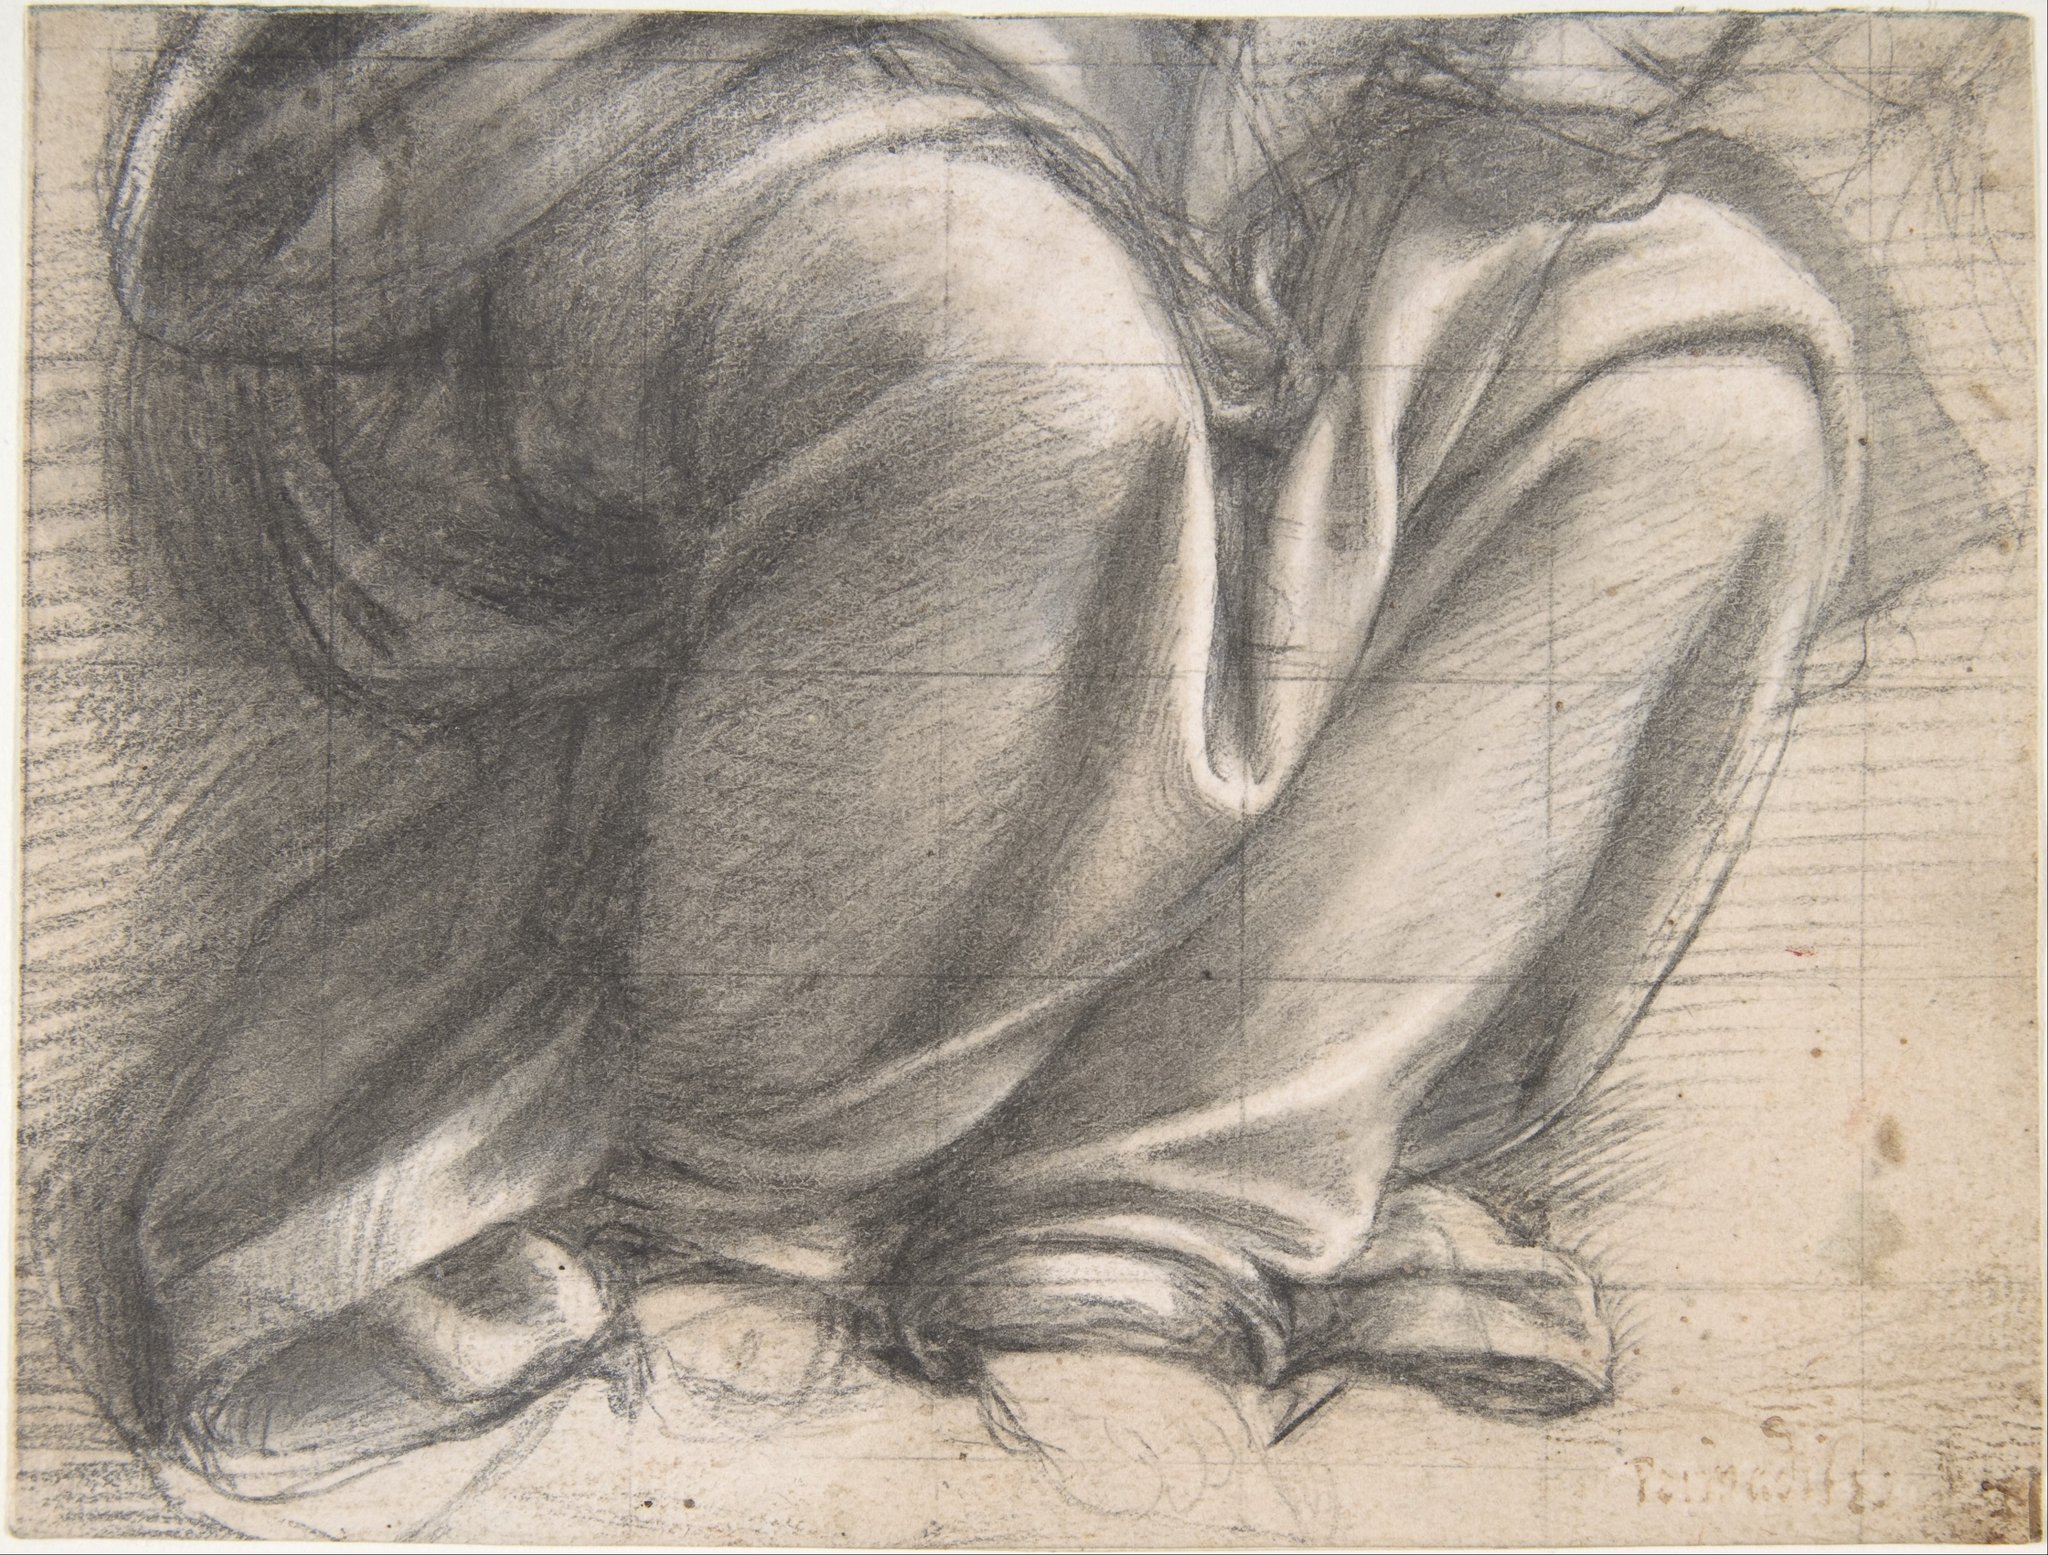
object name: drawing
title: Study of Drapery over the Knees of a Seated Figure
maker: fra bartolomeo (bartolomeo di paolo del fattorino)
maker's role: artist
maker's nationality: italian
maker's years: 1473-1517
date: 1472-1517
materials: chalk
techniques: highlighting, drawing